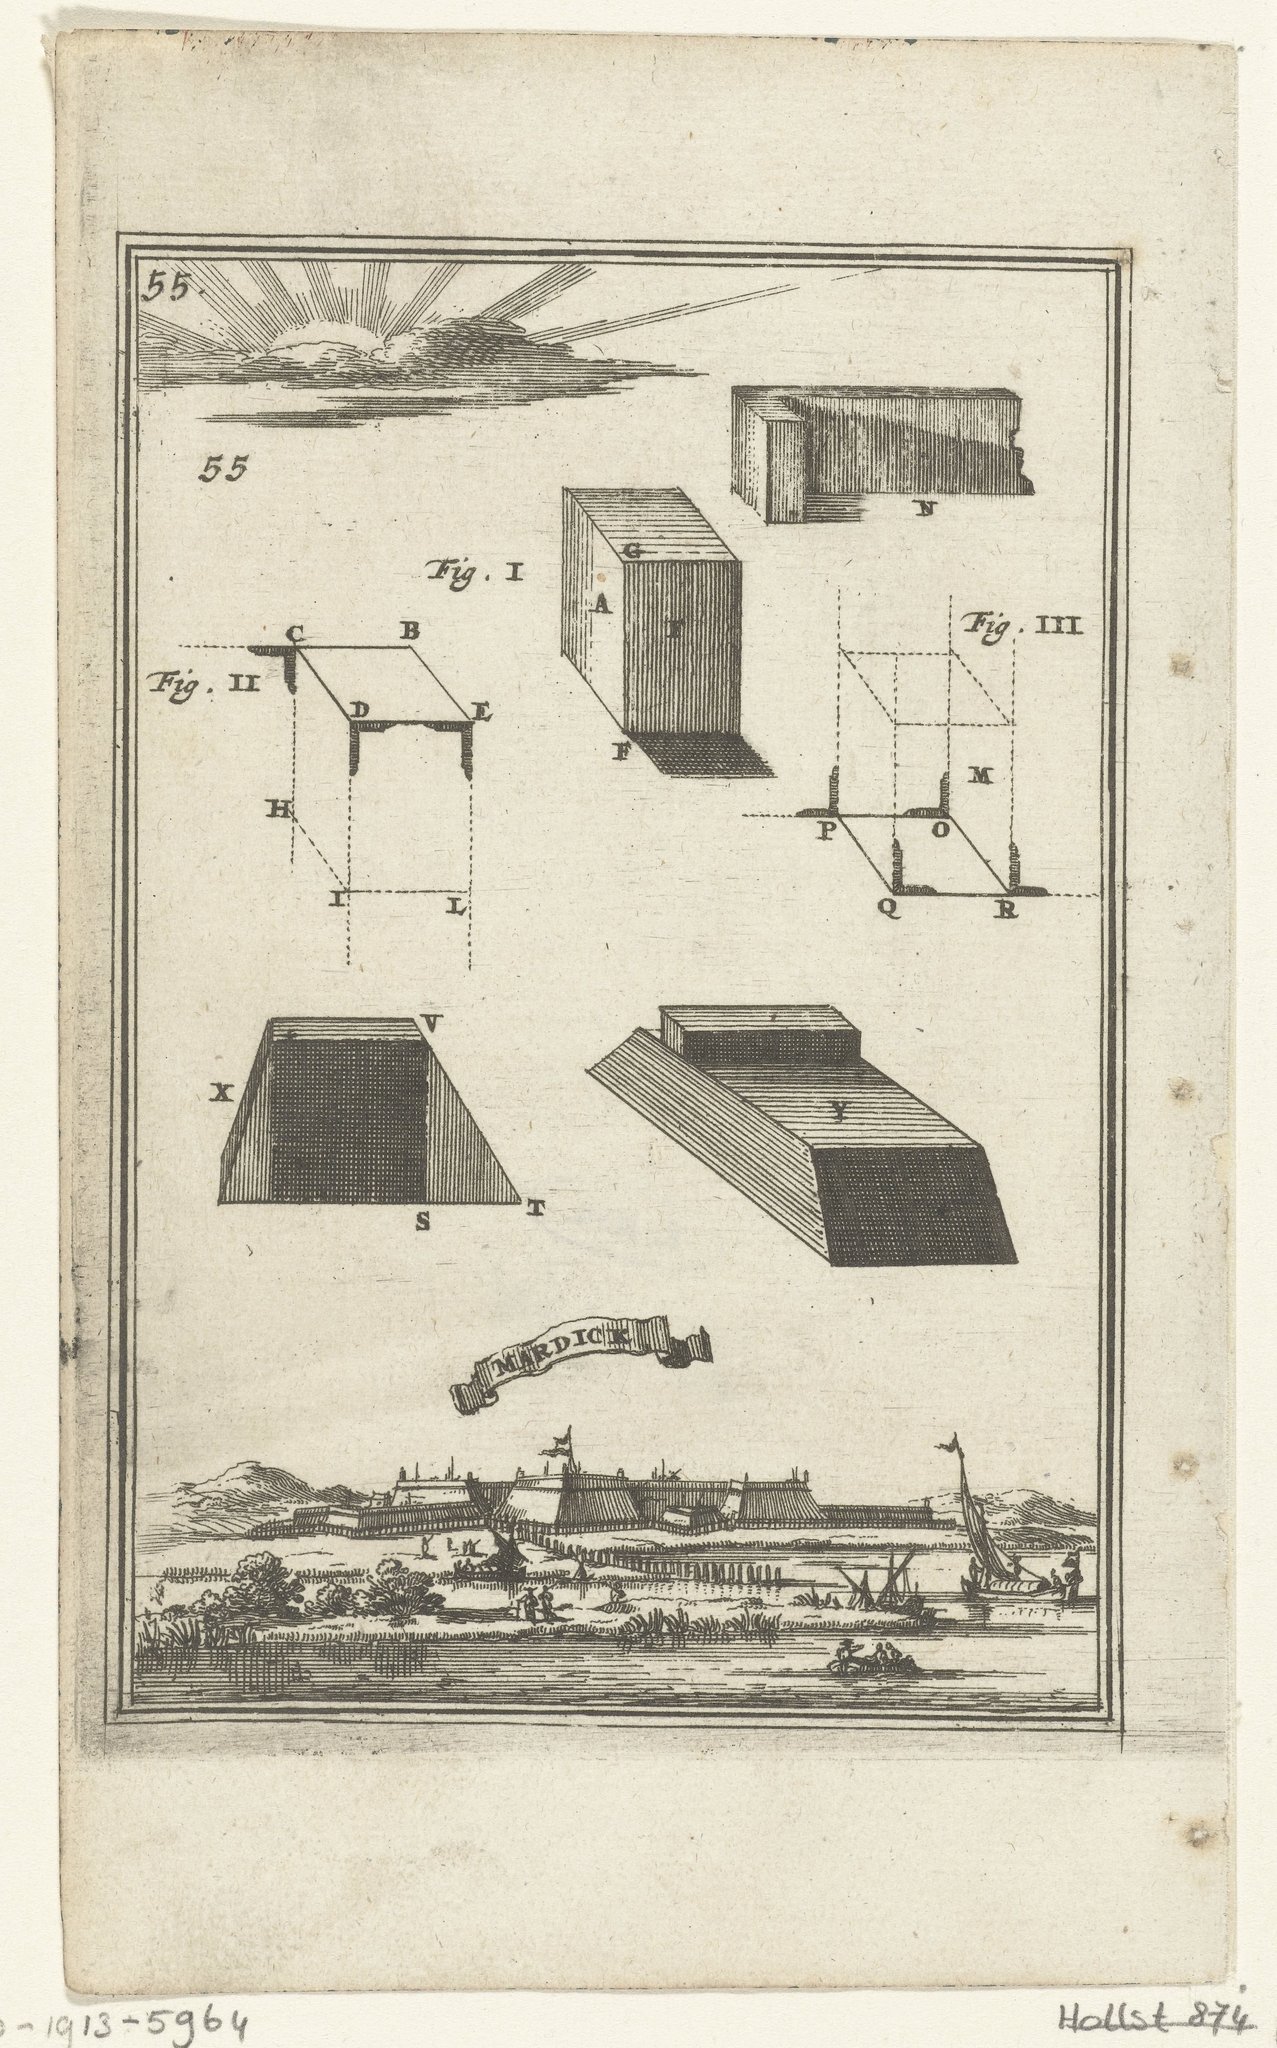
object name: print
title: Illustratie voor 'Den Arbeid van Mars' van Allain Manesson Mallet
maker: romeyn de hooghe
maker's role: draughtsman, goldsmith, painter, print maker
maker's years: 1645-1708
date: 1672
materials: paper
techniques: etching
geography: amsterdam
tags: landscapes with waters, waterscapes, seascapes (in the temperate zone), fortifications, military engineering, coast, prospect of city, town panorama, silhouette of city, mathematics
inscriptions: collector's mark: Lugt 2228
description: Zes wiskundige figuren. Daaronder een gezicht op een stad aan een water (Mardijk). In de hoek linksboven het cijfer 55 (= het nummer van de pagina in het boek waartegenover de illustratie geplaatst is).